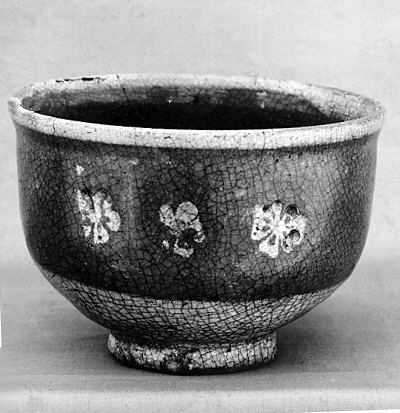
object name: teabowl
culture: japanese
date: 1701-1800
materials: clay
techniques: glazing